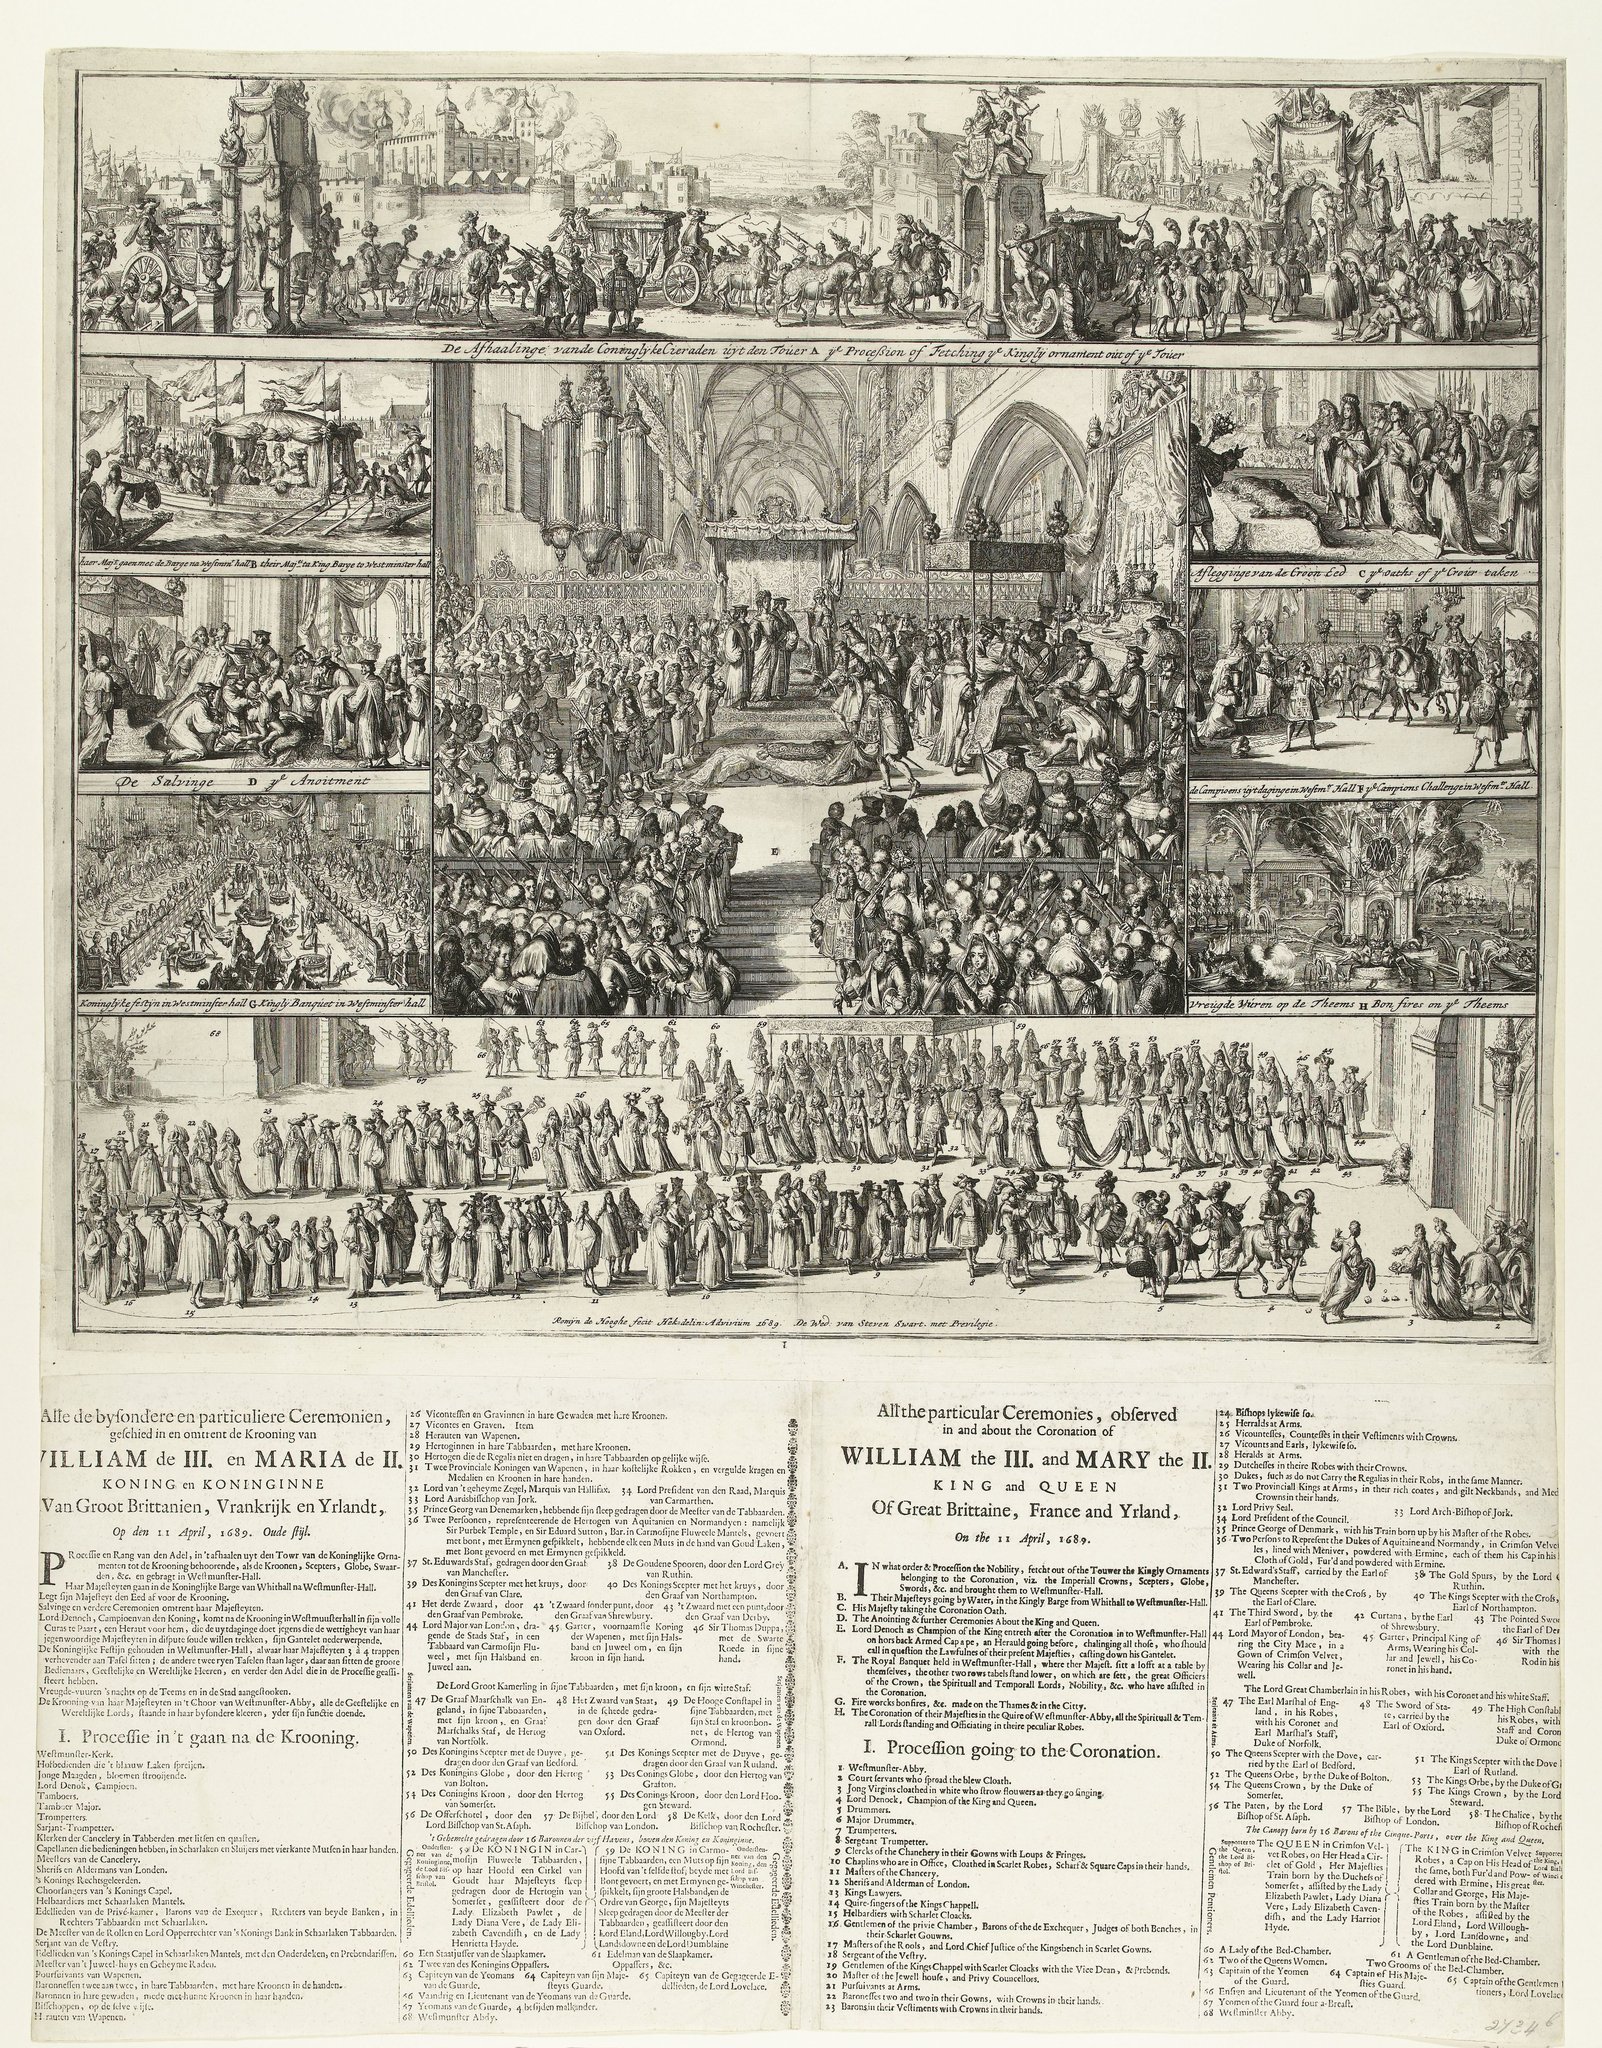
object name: print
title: Alle de bysondere en particuliere Ceremonien, geschied in en omtrent de Krooning van William de III. en Maria de II. Koning en Koninginne Van Groot Brittanien, Vrankrijk en Yrlandt, Op den 11 April, 1689. Oude stijl.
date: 1689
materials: paper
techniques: etching, letterpress printing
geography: northern netherlands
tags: william iii (prince of orange and king of england, scotland, and ireland), london, maria ii stuart (koningin van engeland, schotland en ierland), coronation of a ruler, bonfire, fire-works, westminster abbey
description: Overzicht in één grote en acht kleinere scènes van de procedures en ceremoniën rond de kroning van Willem en Maria tot koning en koningin van Engeland in de Westminster Abbey, 21 april 1689. Onder meer het ophalen van de kroonjuwelen uit de Tower, de processie, de feestmaaltijd in Westminster Hall en de vreugdevuren op de Thames. Vastgeplakt onder de prent een tekstblad met een beschrijving van de gebeurtenissen en de legenda's A-H en 1-68 in 4 kolommen in het Nederlands en Engels.